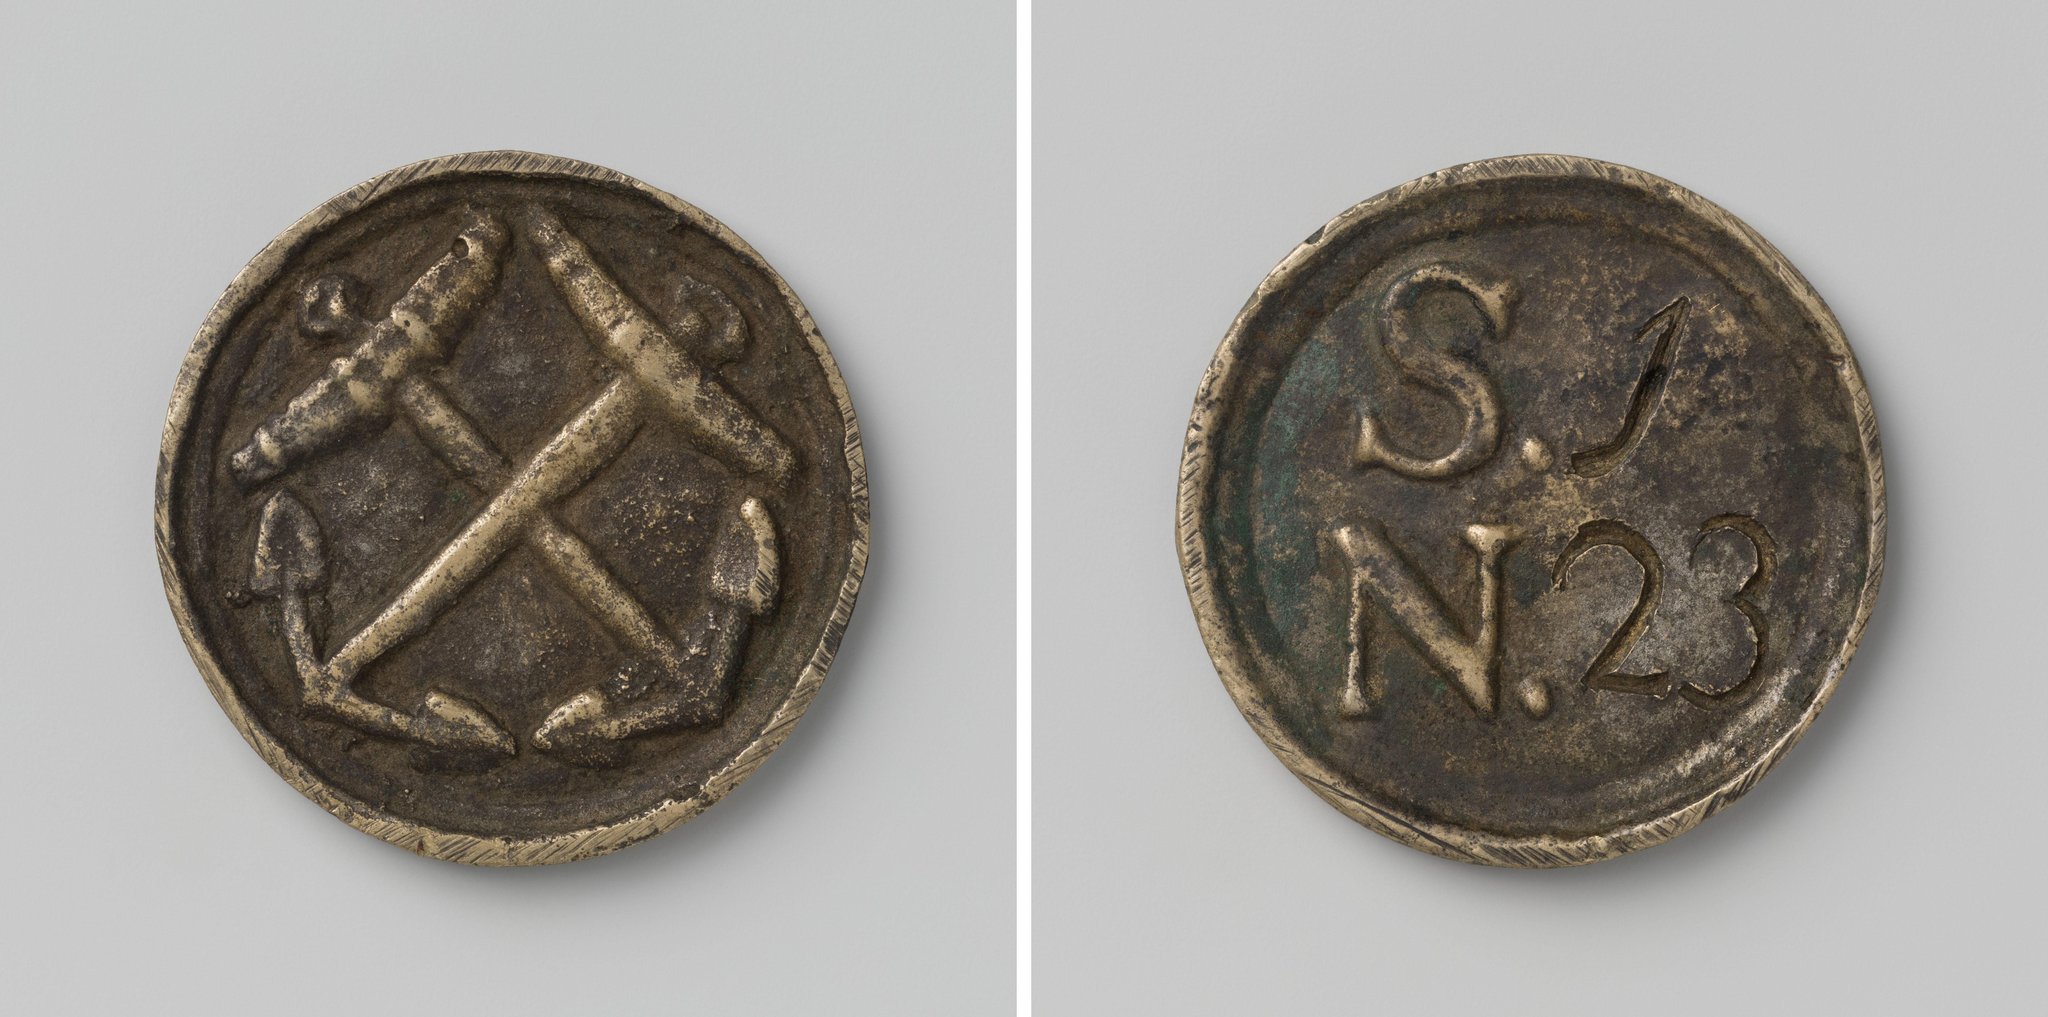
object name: fire engine medal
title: Brandspuitpenning van marinewerf van spuit 1 met no. 23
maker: Anonymous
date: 1680-1800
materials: brass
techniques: casting, engraving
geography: netherlands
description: Messing penning. Voorzijde: twee gekruiste ankers. Keerzijde: opschrift